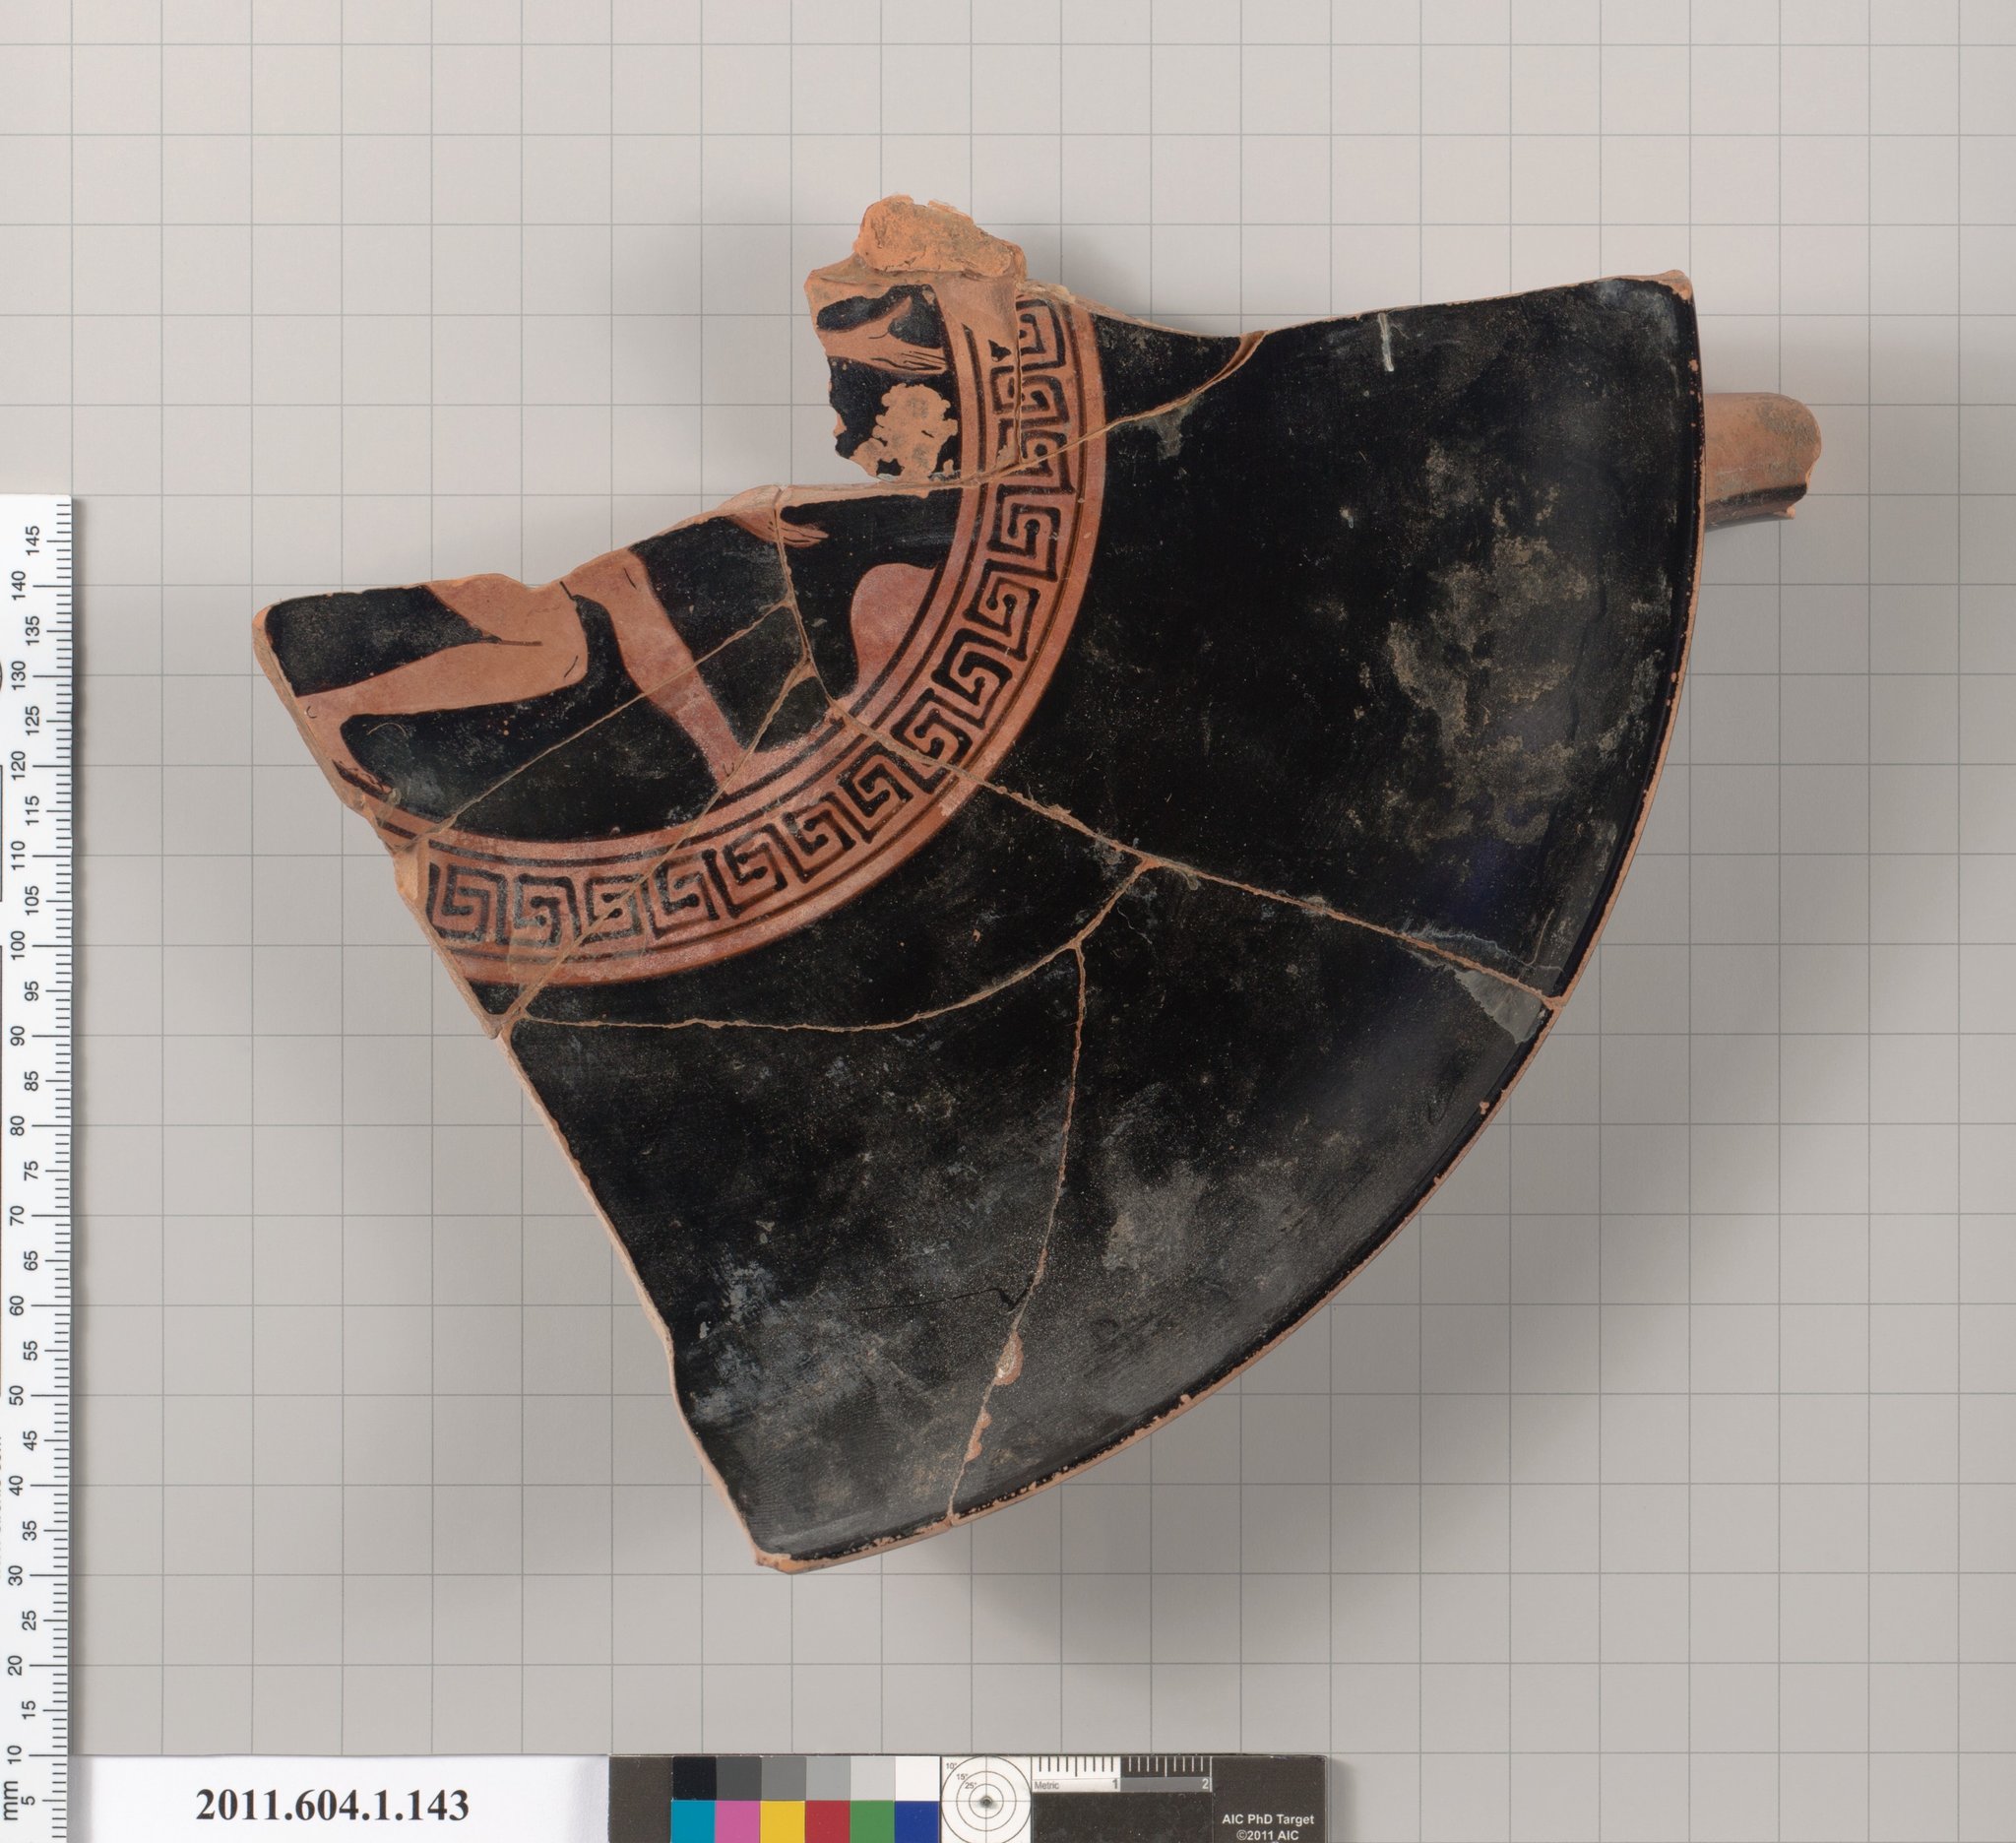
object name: kylix fragment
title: Terracotta fragment of a kylix (drinking cup)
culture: greek, attic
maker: veii painter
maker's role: artist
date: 475-451 BCE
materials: terracotta